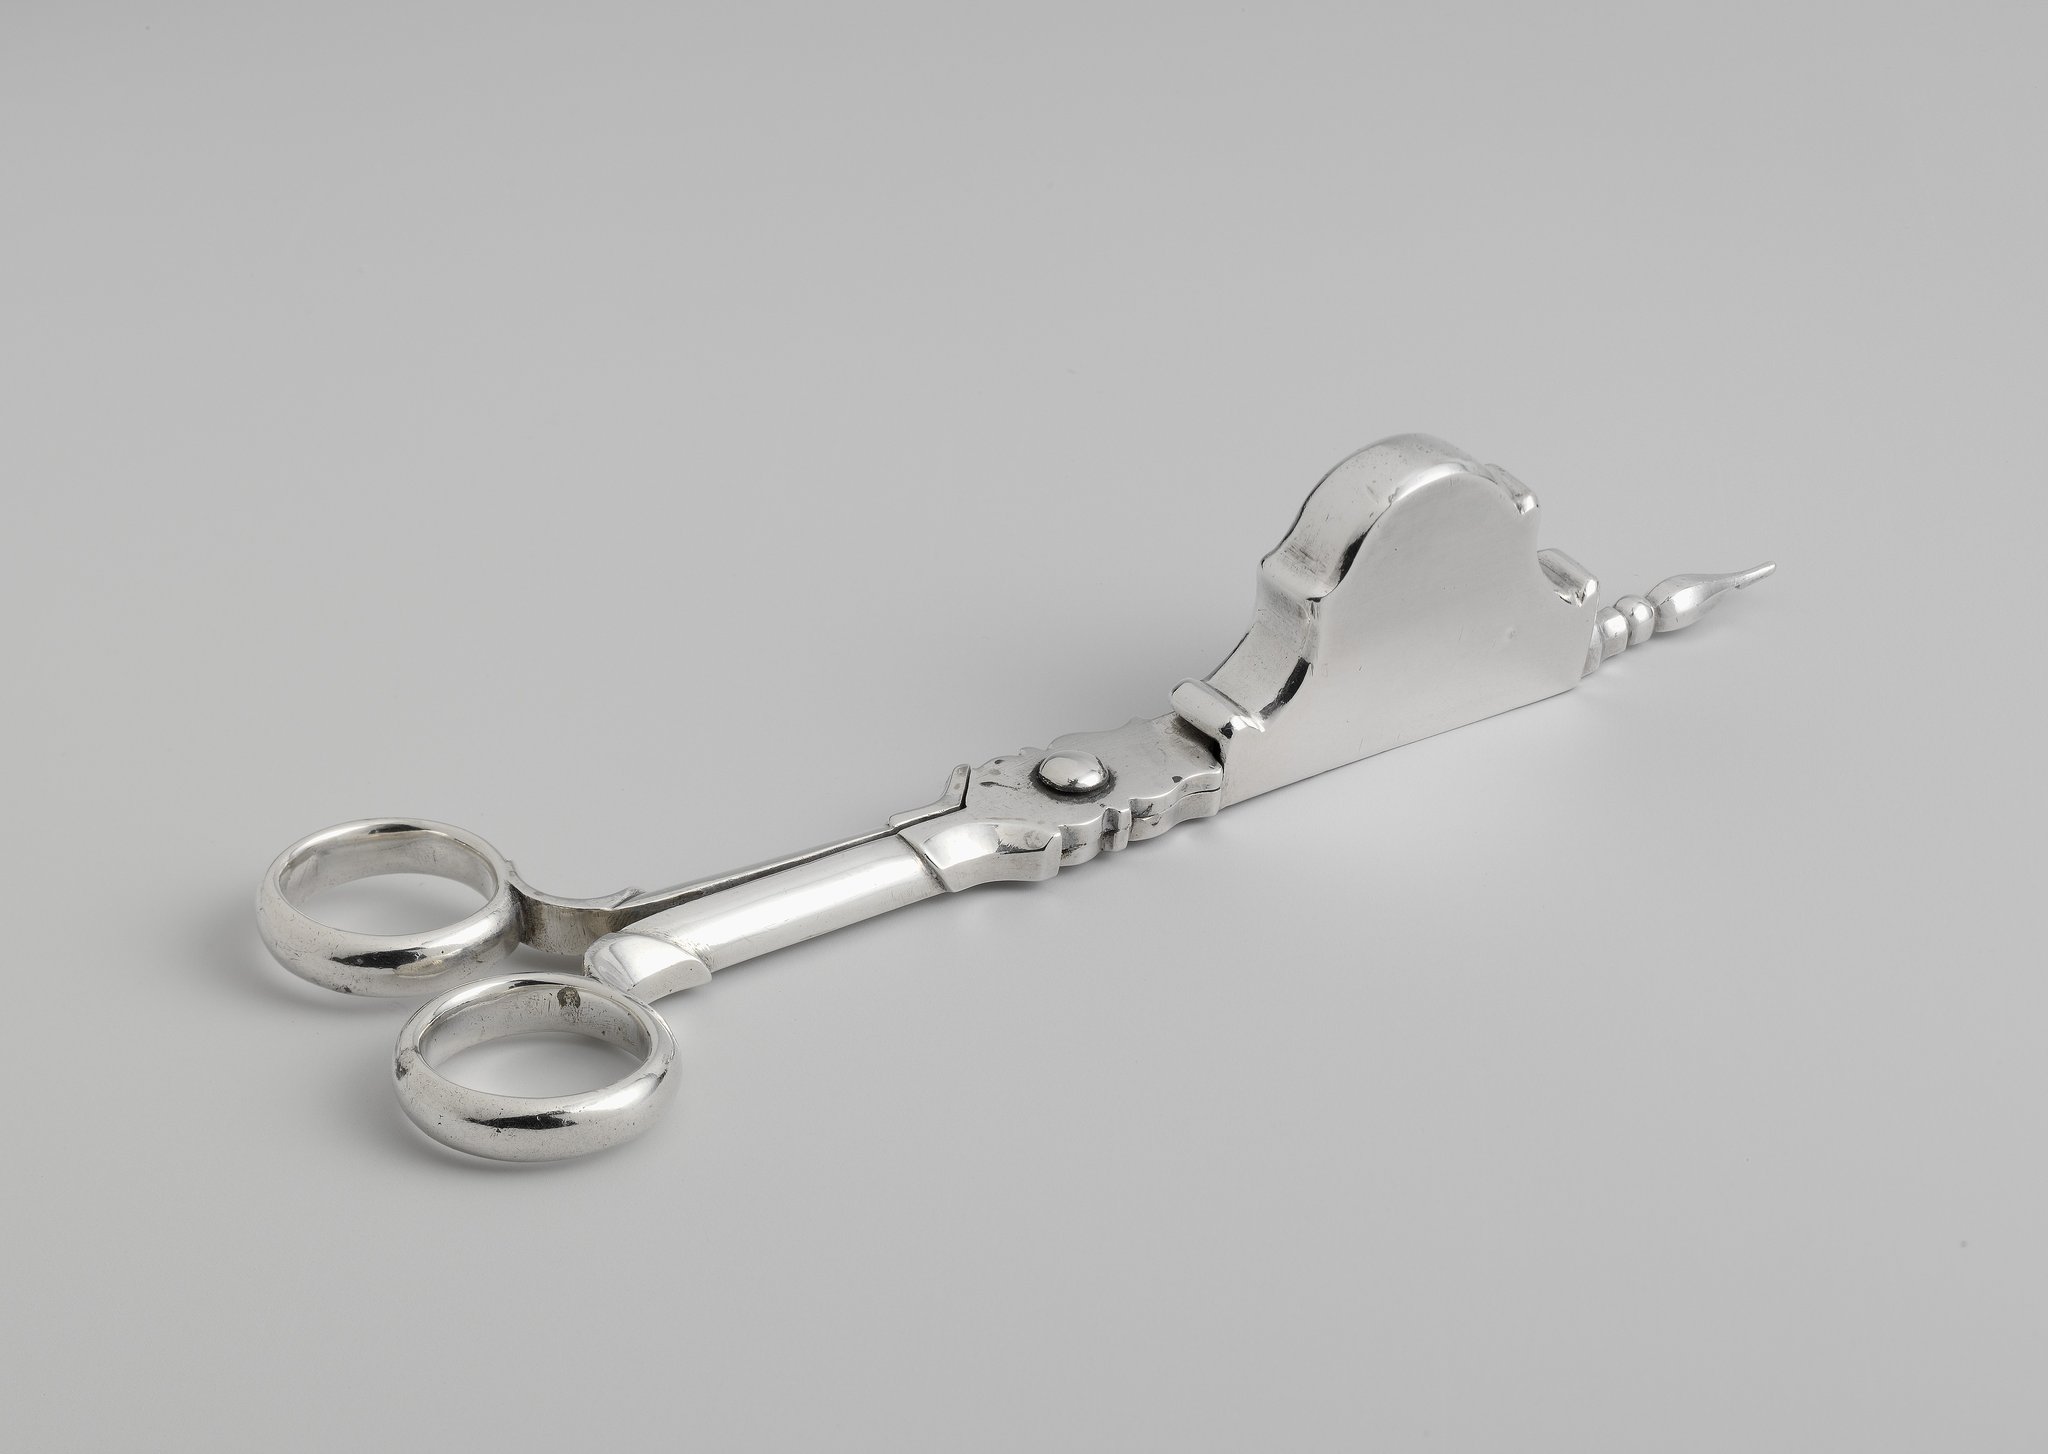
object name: snuffer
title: Snuffers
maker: rené briceau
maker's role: maker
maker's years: 1669-1750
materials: silver